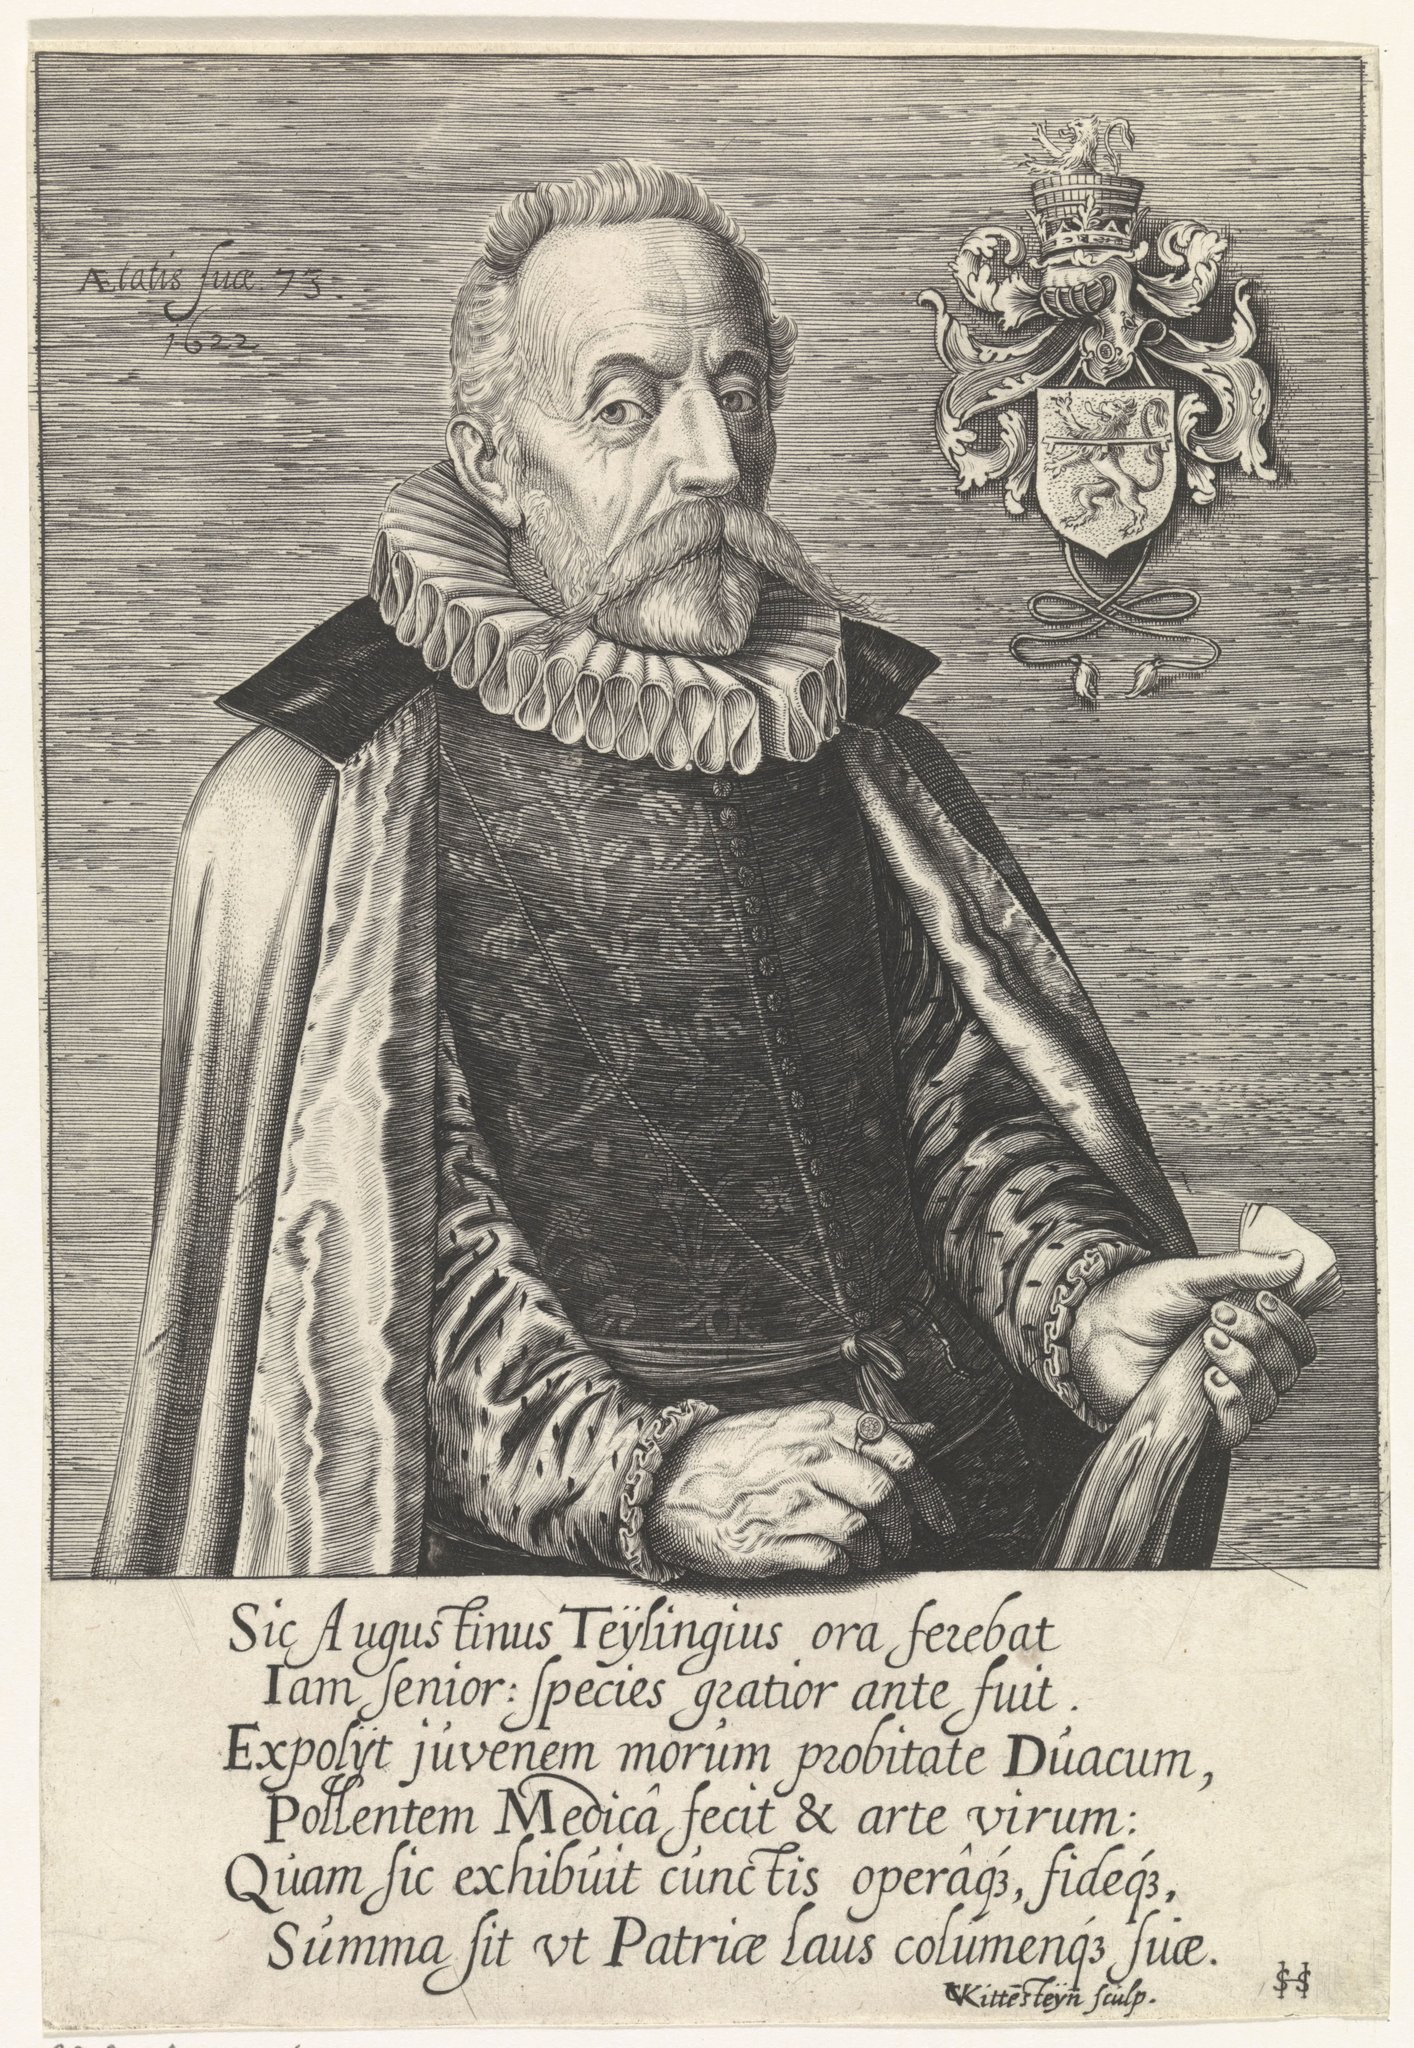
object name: print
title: Portret van Augustijn van Teylingen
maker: cornelis van kittensteyn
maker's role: print maker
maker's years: 1597-1663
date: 1622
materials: paper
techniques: engraving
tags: neck-gear ~ clothing (with name), cape (+ men's clothes), gloves, mittens, etc. (+ men's clothes)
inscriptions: collector's mark: Lugt 2228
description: Portret van de 73-jarige Augustijn van Teylingen, dokter in Douay en Haarlem. Hij draagt een mantel en een plooikraag en houdt twee handschoenen in zijn linkerhand. Tegen de muur een wapenschild en onder de afbeelding een zesregelige Latijnse tekst.